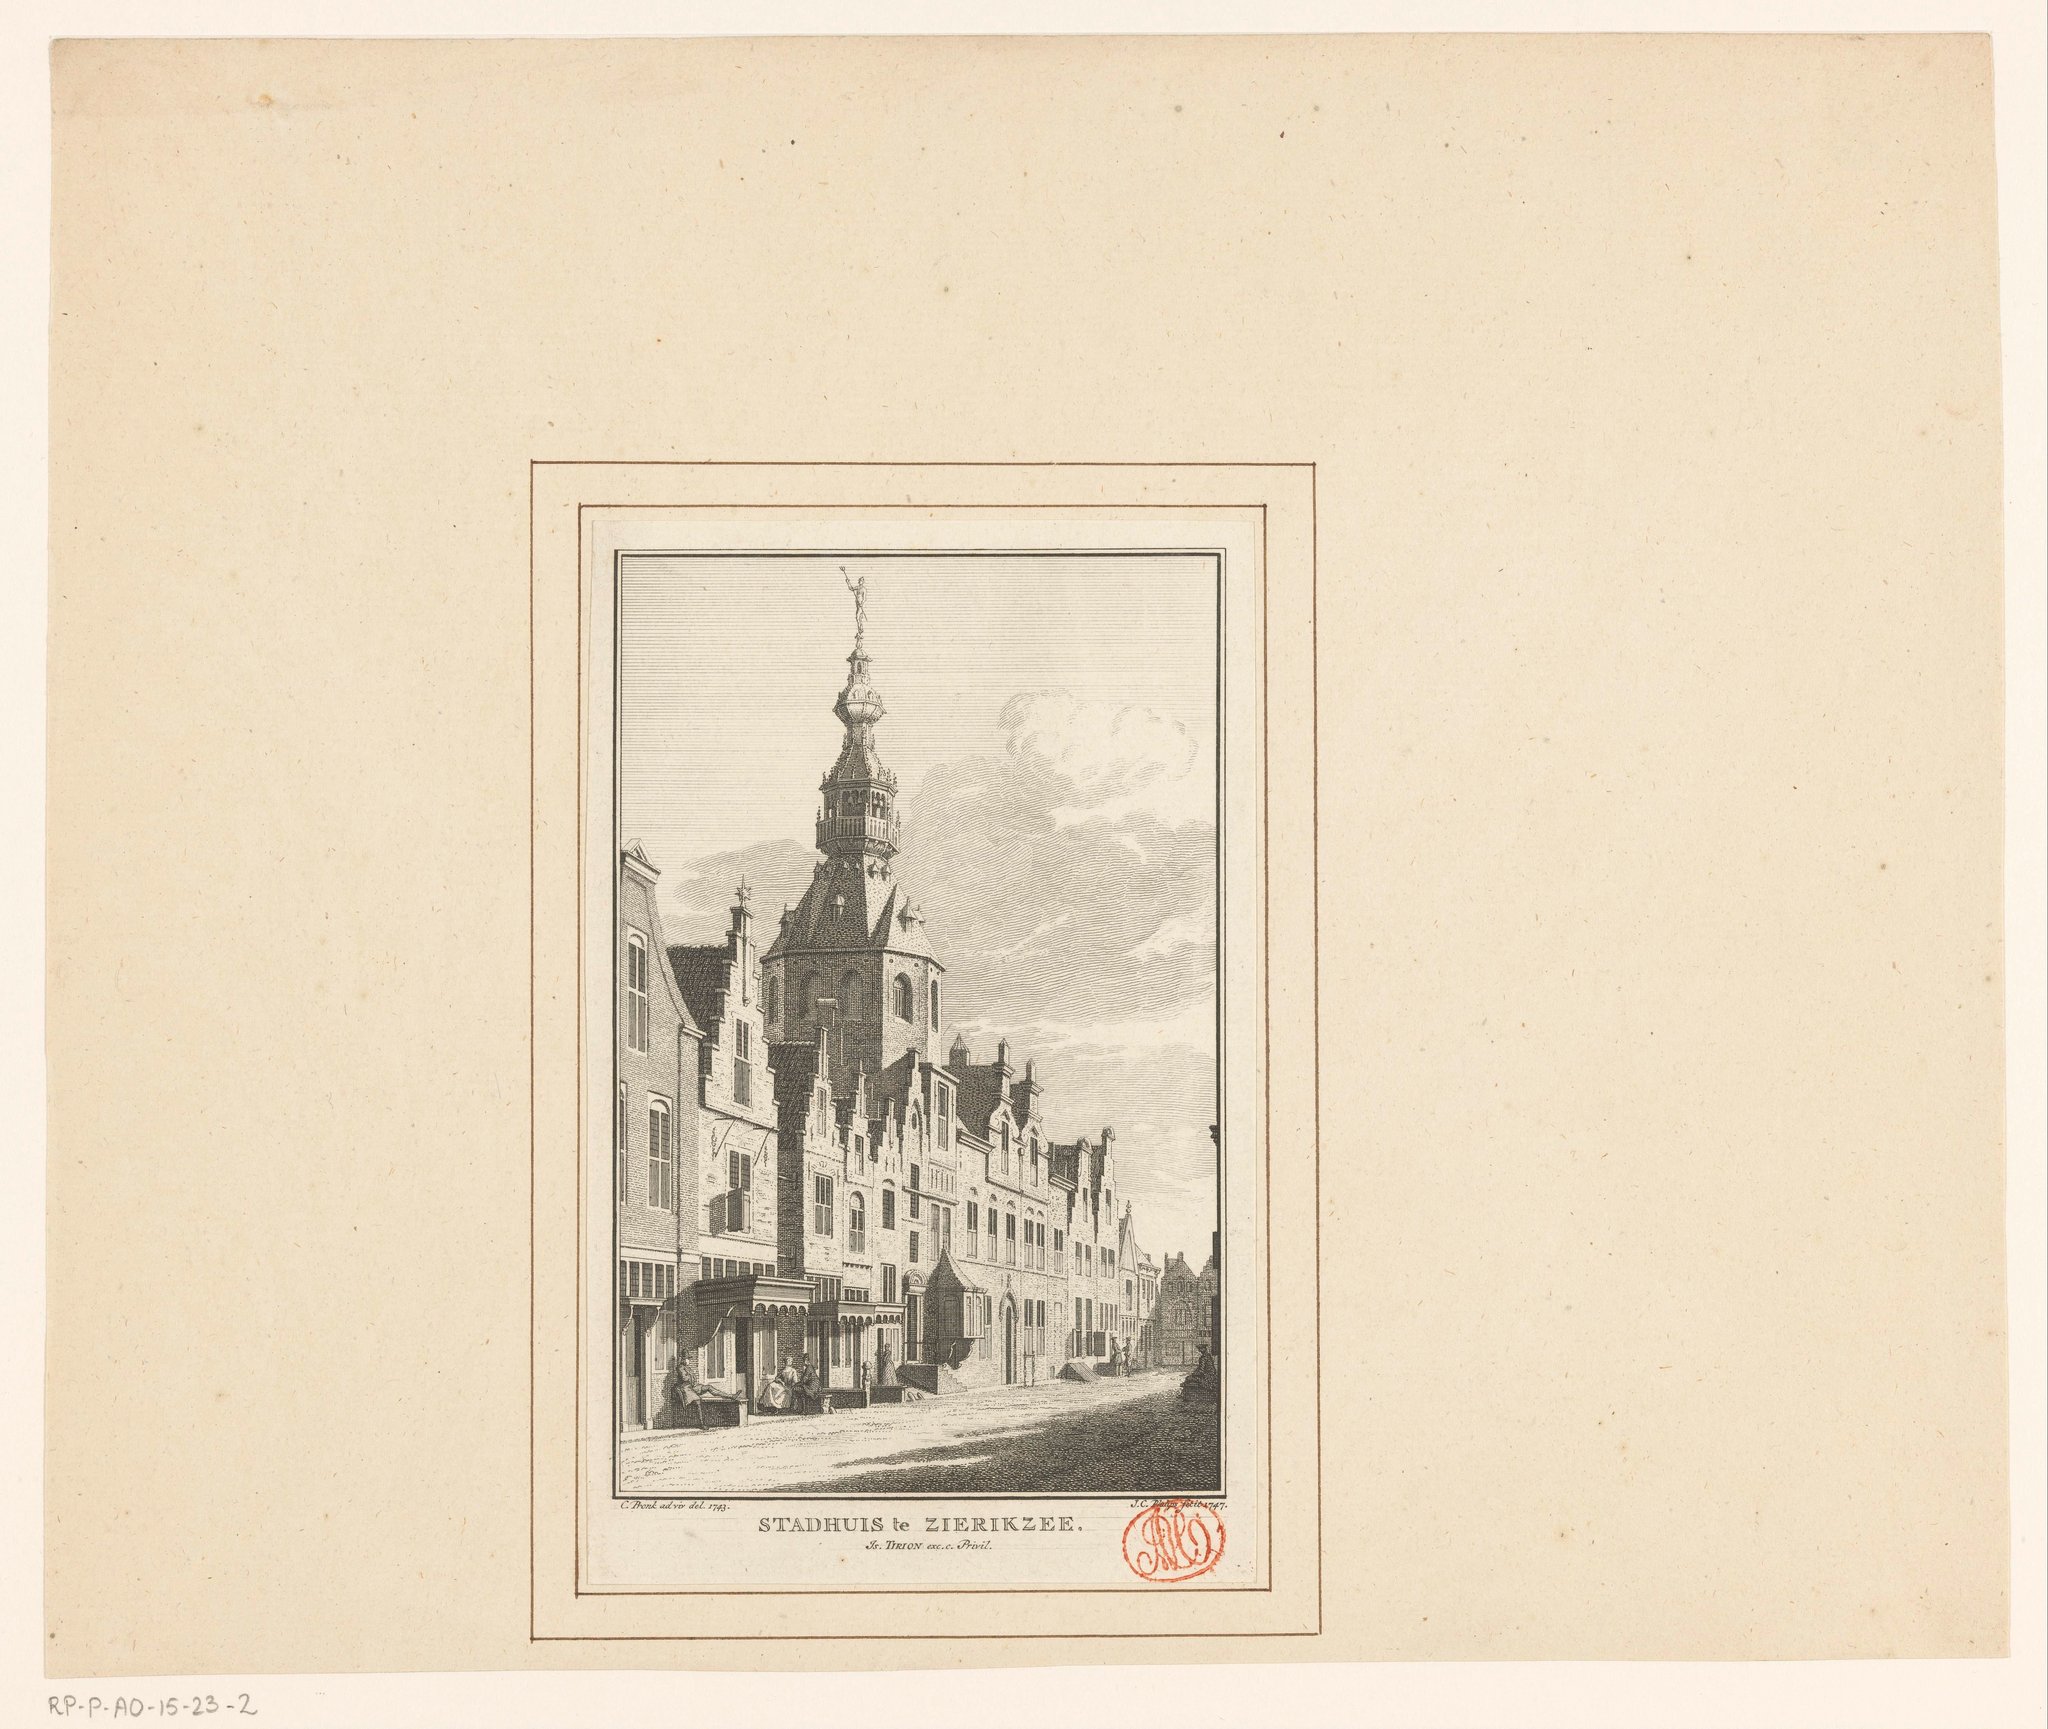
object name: book illustration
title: Stadhuis te Zierikzee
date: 1747-1760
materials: paper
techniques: engraving, etching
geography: amsterdam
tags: townhall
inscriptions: collector's mark: Lugt 195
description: Gezicht op het stadhuis van Zierikzee, gelegen in de Meelstraat, in de situatie omstreeks 1743.